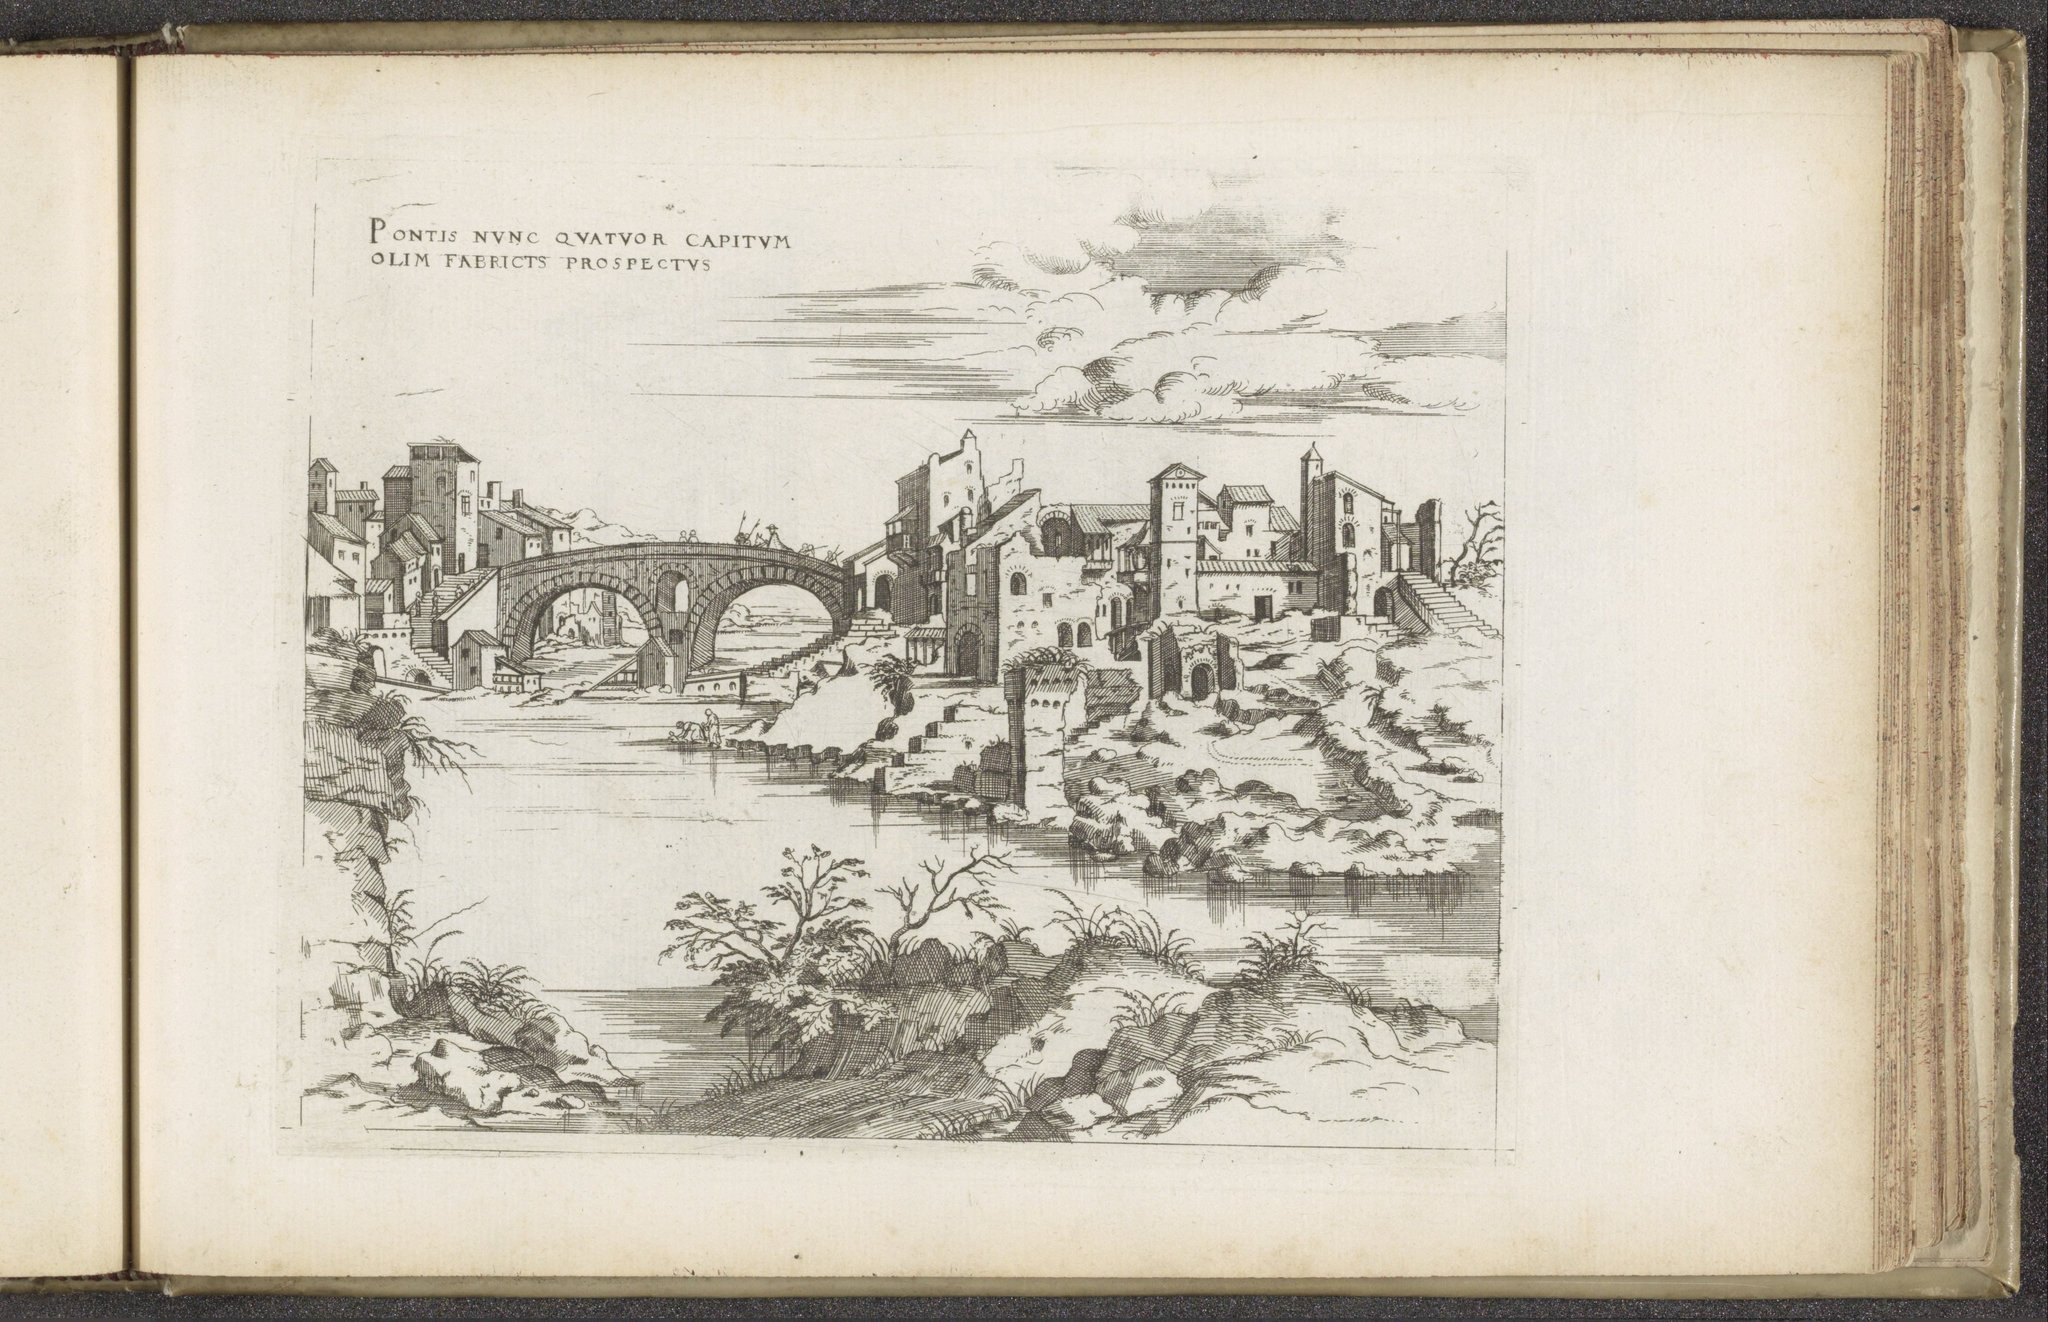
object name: print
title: Praecipva Aliqvot Romanae Antiqvitatis Rvinarum Monimenta Vivis Prospectibus Ad Veri Imitationem Affabre Designata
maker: jacques androuet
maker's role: draughtsman, print maker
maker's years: 1515-1584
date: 1551-1584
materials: paper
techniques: etching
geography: france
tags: bridge in city across river, canal, etc.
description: Gezicht op de brug van Fabricius te Rome, rechts het Tibereiland. Deze prent maakt deel uit van een album.